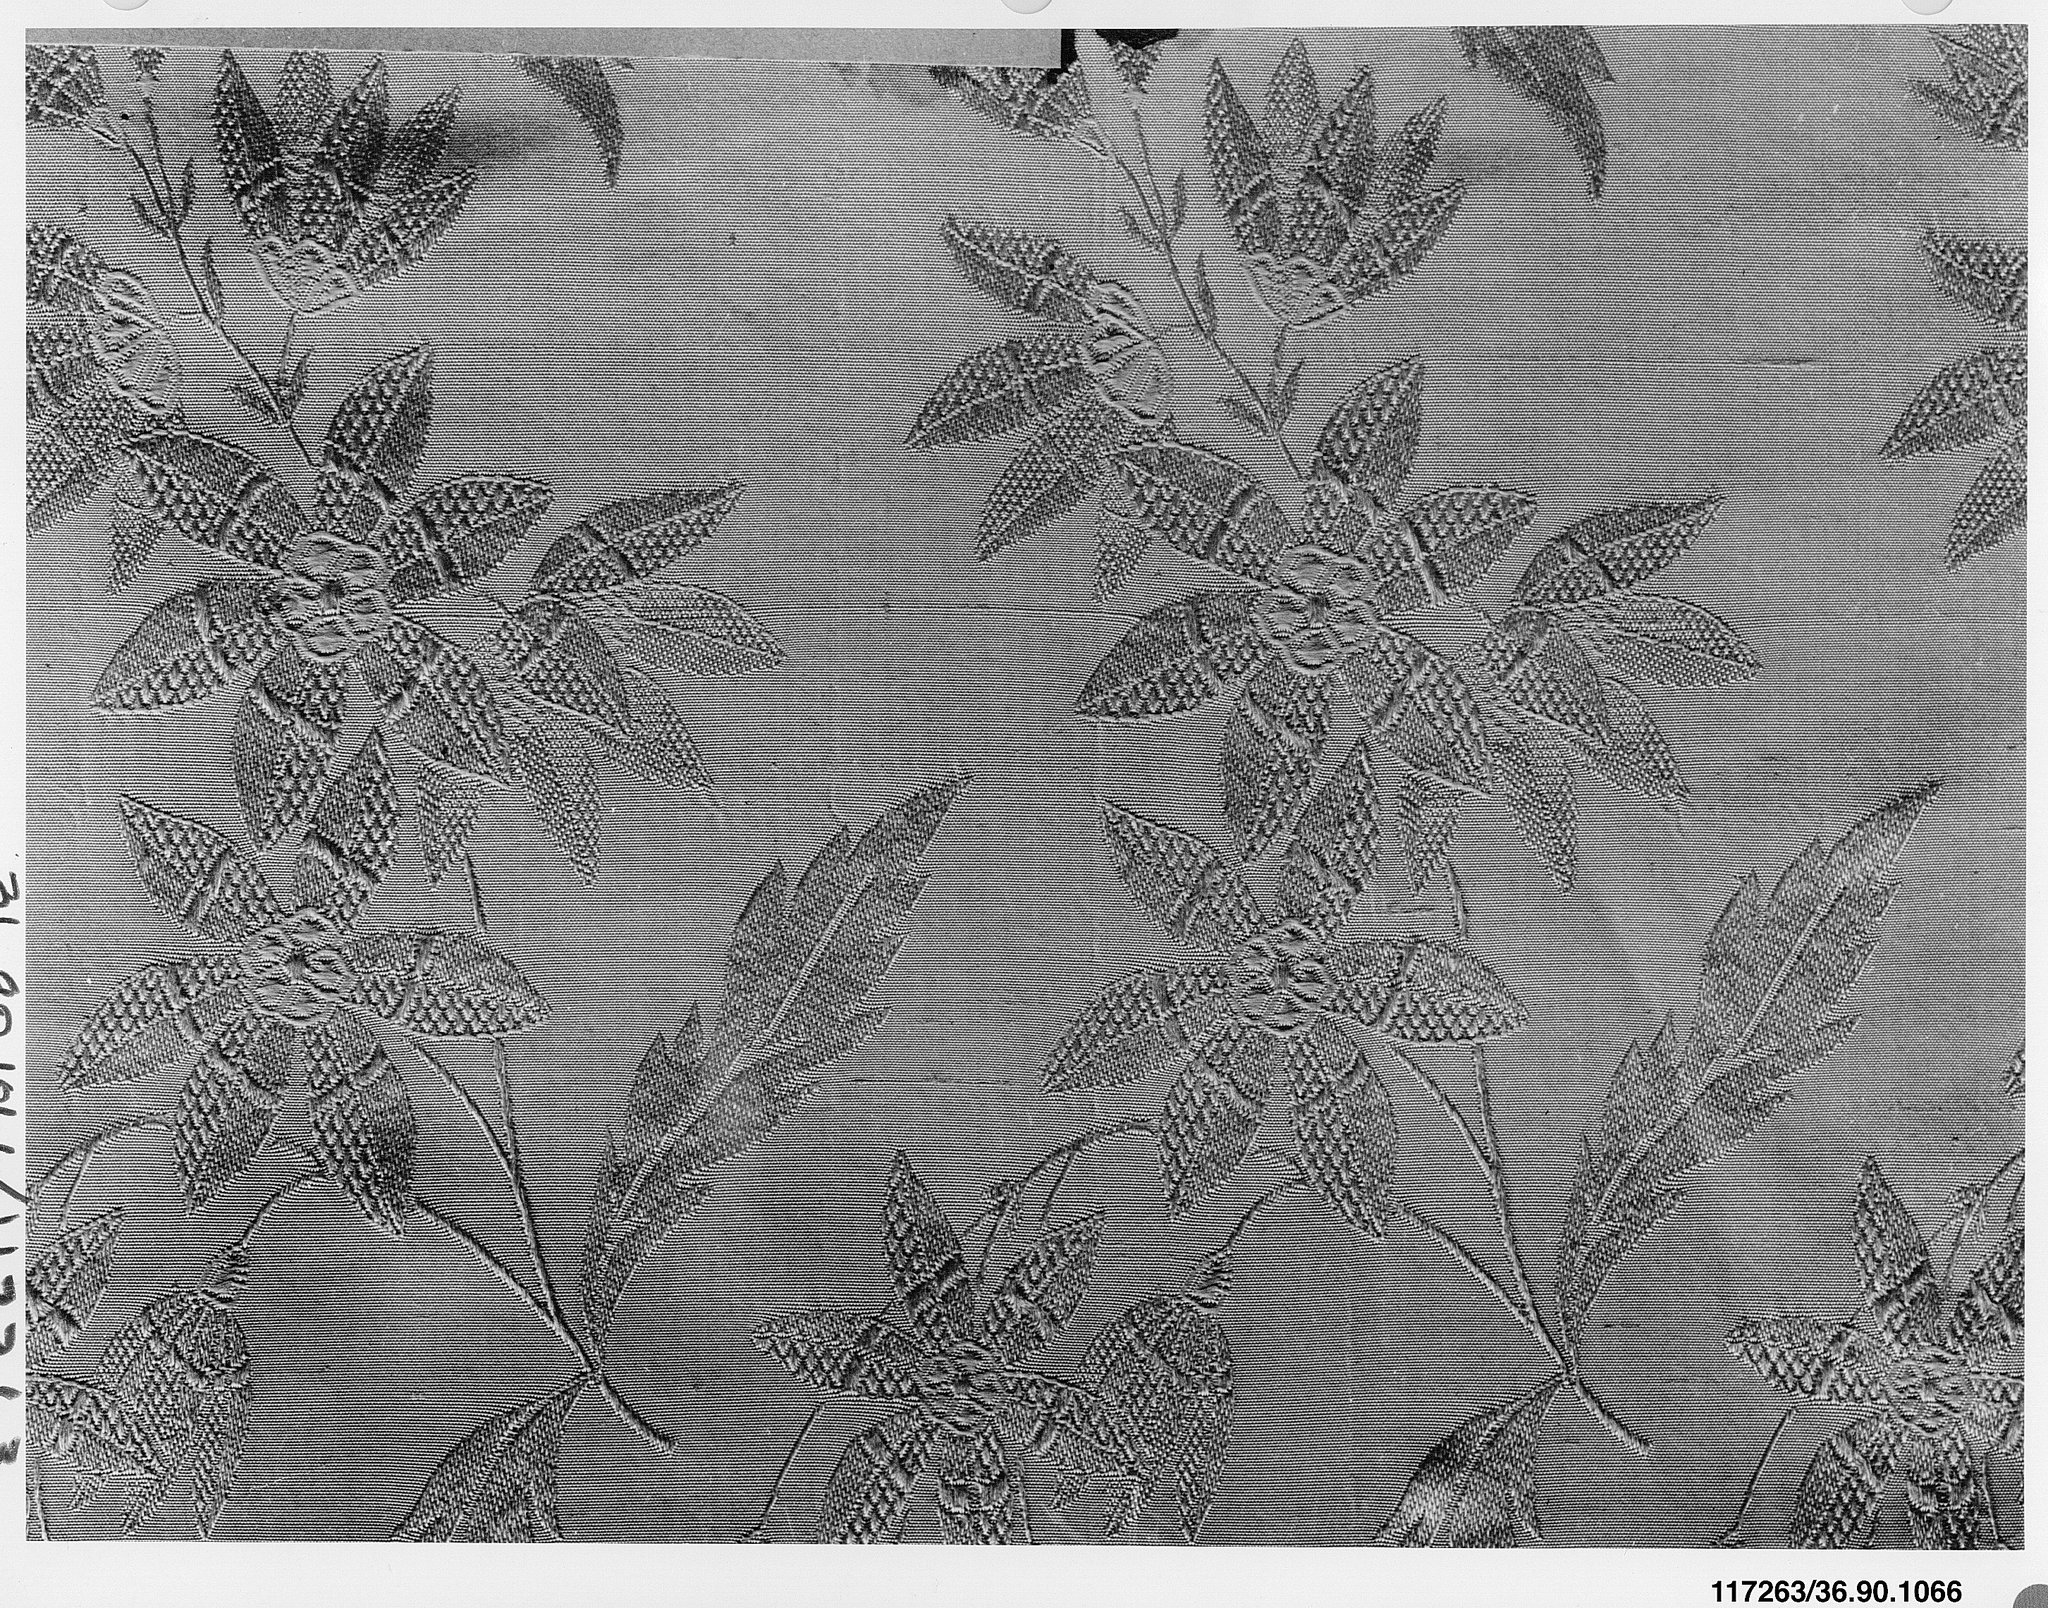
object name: piece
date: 1801-1900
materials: silk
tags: flowers,leaves